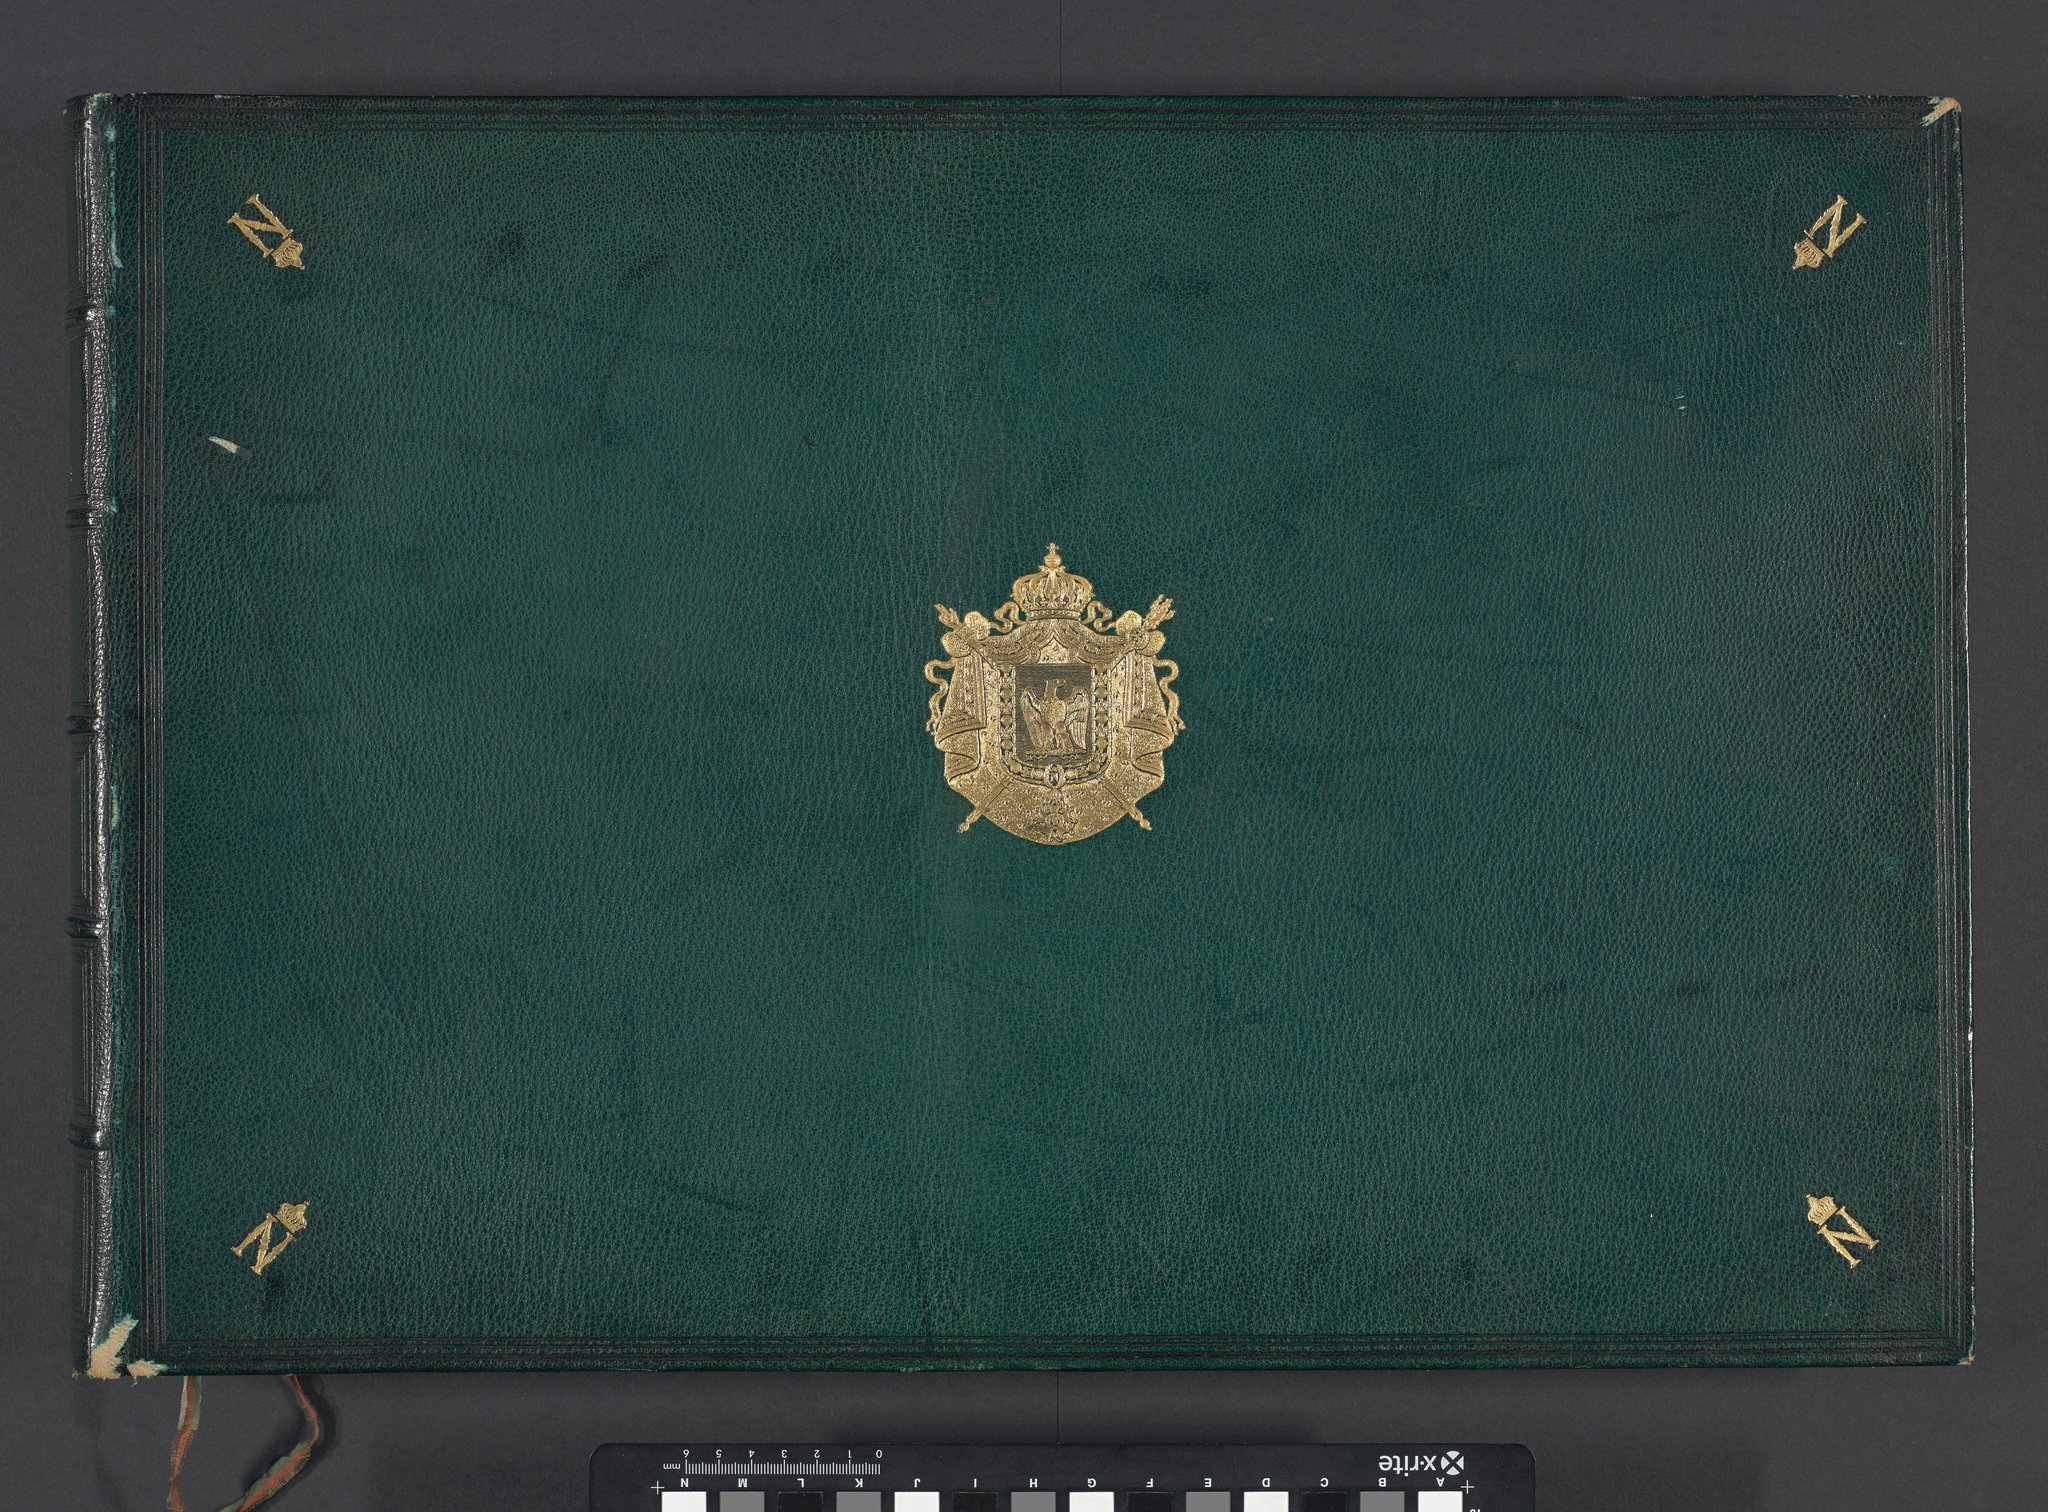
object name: scrapbook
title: Réunion des Tuileries au Louvre, album 1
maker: édouard denis baldus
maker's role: fotograaf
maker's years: 1813-1889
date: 1854-1857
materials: cardboard, leather, paper, photographic support, textile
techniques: engraving, salted paper print, writing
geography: paris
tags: permanent exhibition, museum, paris, tuileries palace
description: Fotoalbum in groen leren omslag. Op de voor- en achterzijde prijkt het wapenschild van de Franse keizer Napoleon III, in de hoeken zijn monogram. Op de rugband wordt de titel vermeld en het deelnummer. De schutbladen zijn van groen changeant met een randversiering van Franse lelies in gouddruk. Het album bevat 113 bladen met goud op snee die elk één of twee foto's bevatten. Het album maakt deel uit van een ensemble van vier waarmee de bouw van het nieuwe Louvre tussen 1854 en 1857 stap voor stap werd gedocumenteerd in opdracht van de Franse regering. De albums werden als representatie-exemplaren aangeboden aan de keizer, bevriende staatshoofden, ministers (zoals het exemplaar van het Rijksmuseum) en bibliotheken. Er werden 36 van dergelijke sets samengesteld, elk met ongeveer 550 foto's. Slechts vier ensembles zijn bewaard gebleven.